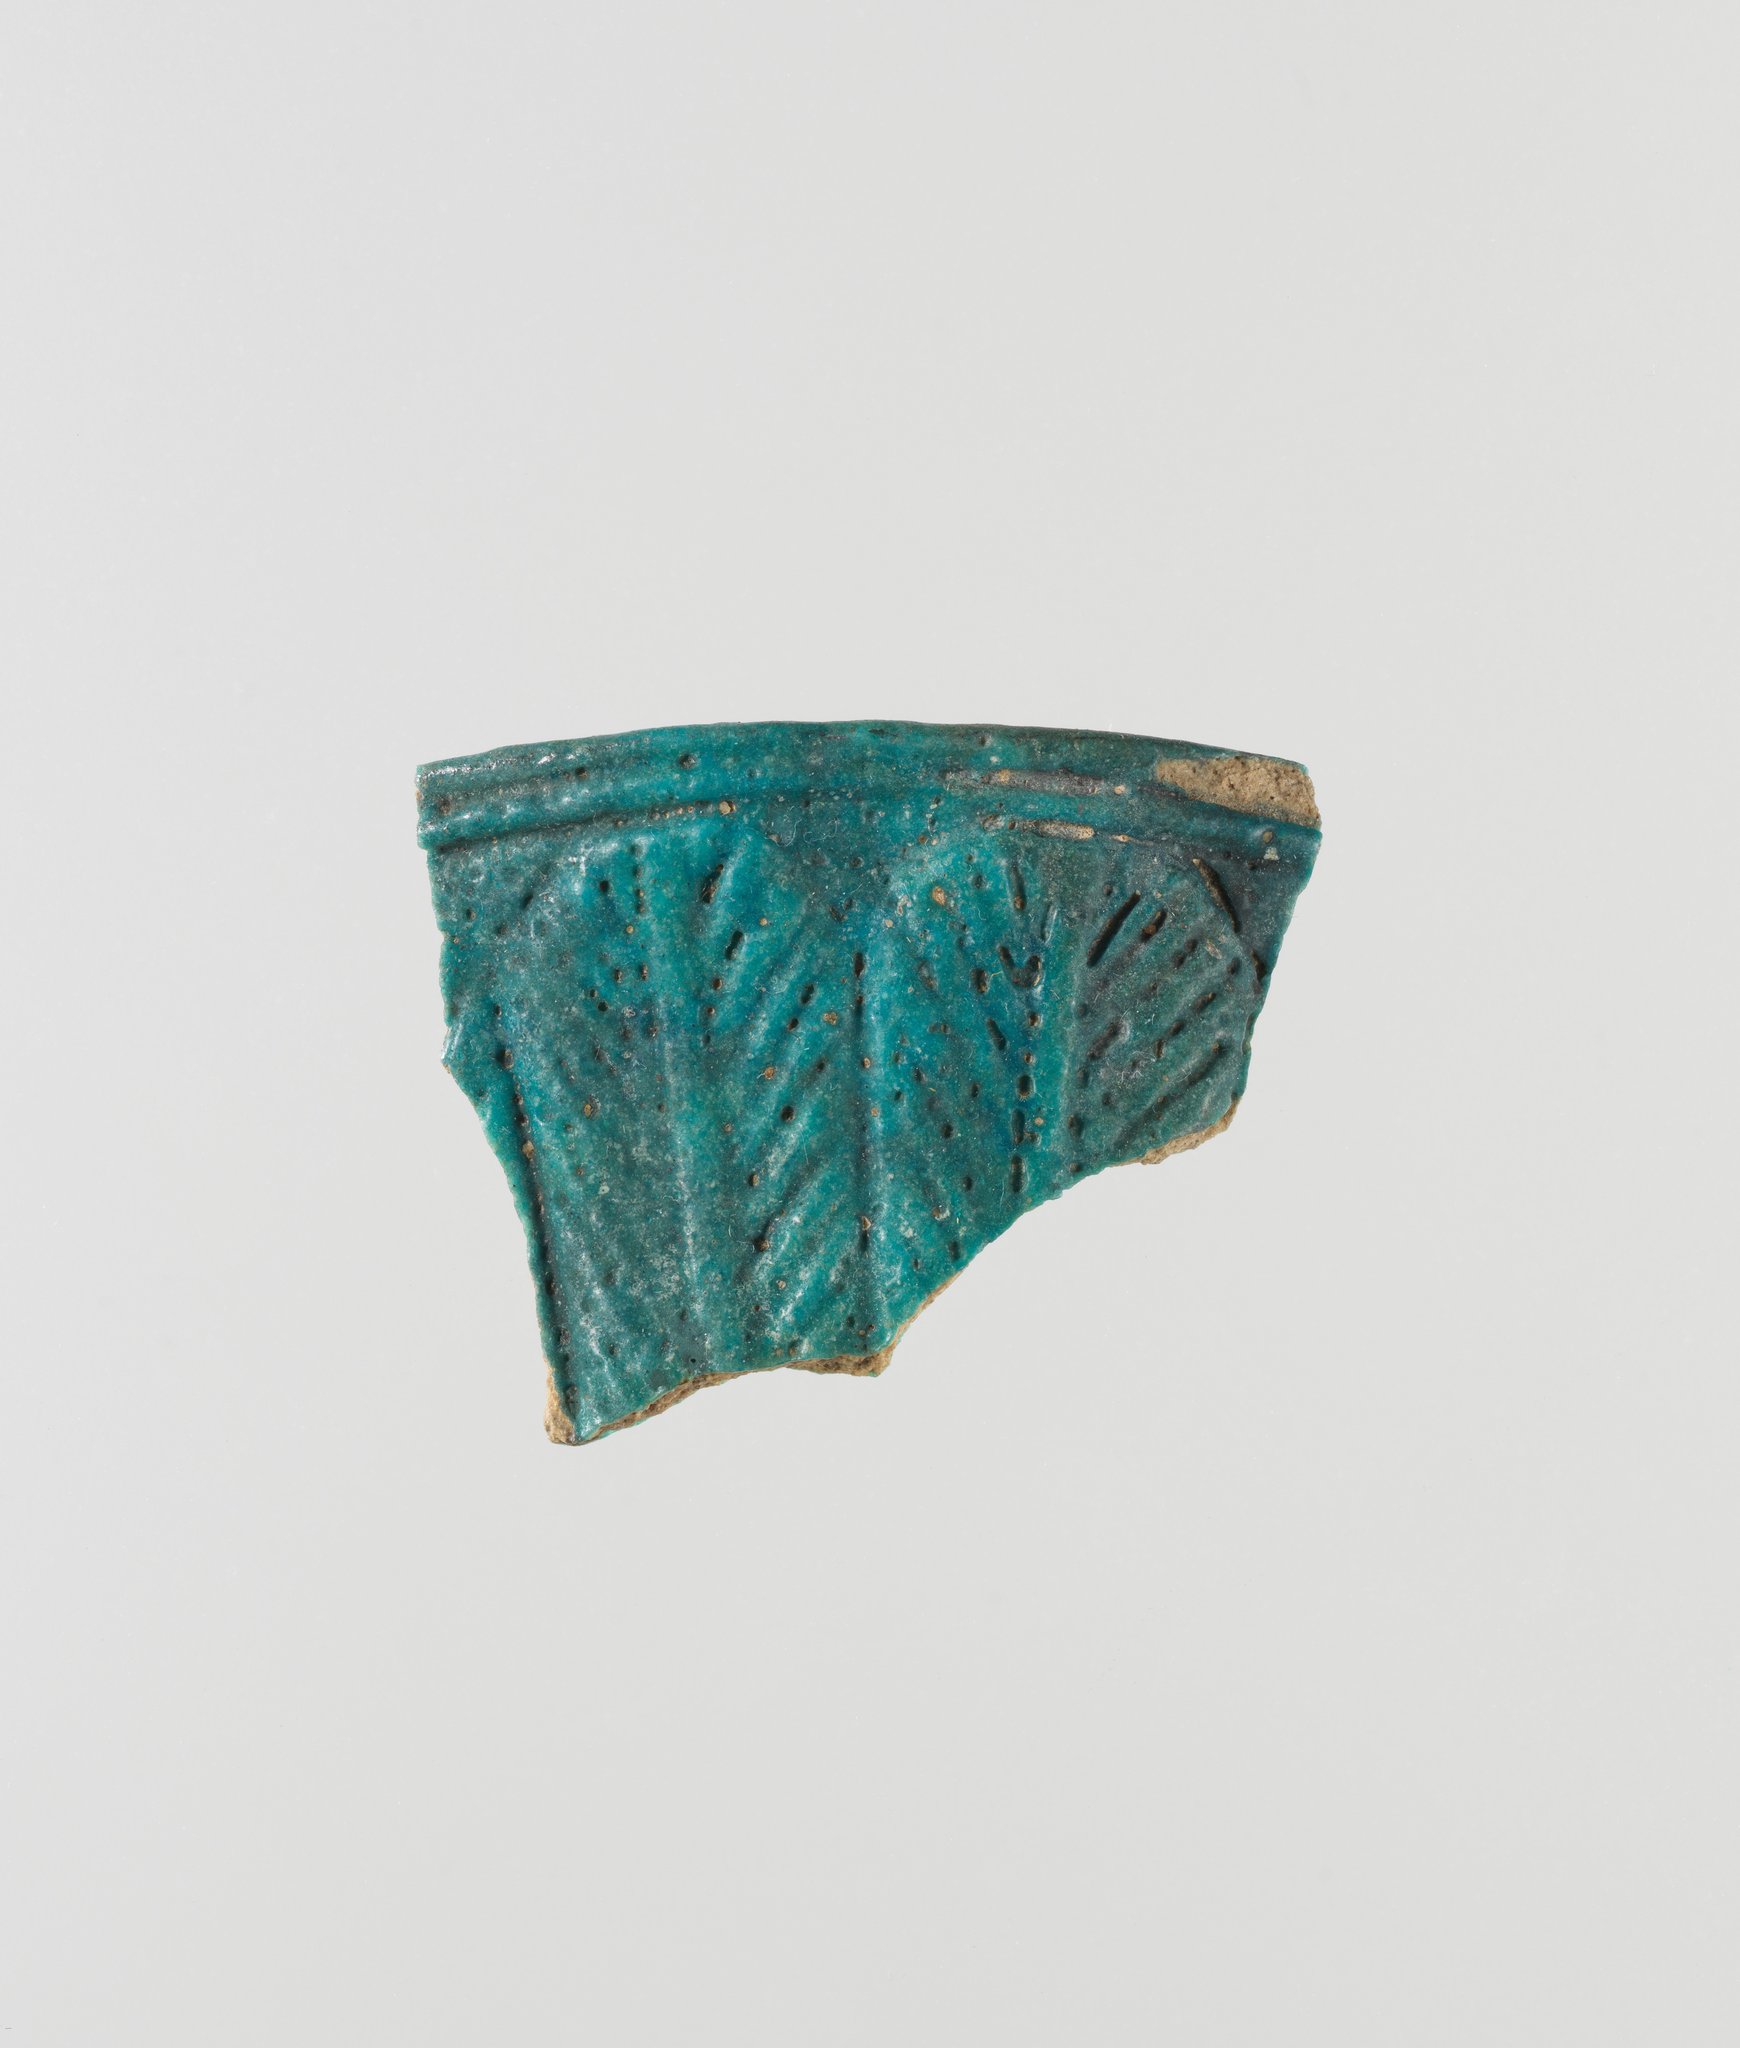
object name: chalice, cup, lotiform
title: Chalice rim fragment with palm fronds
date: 1070-664 BCE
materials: faience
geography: egypt